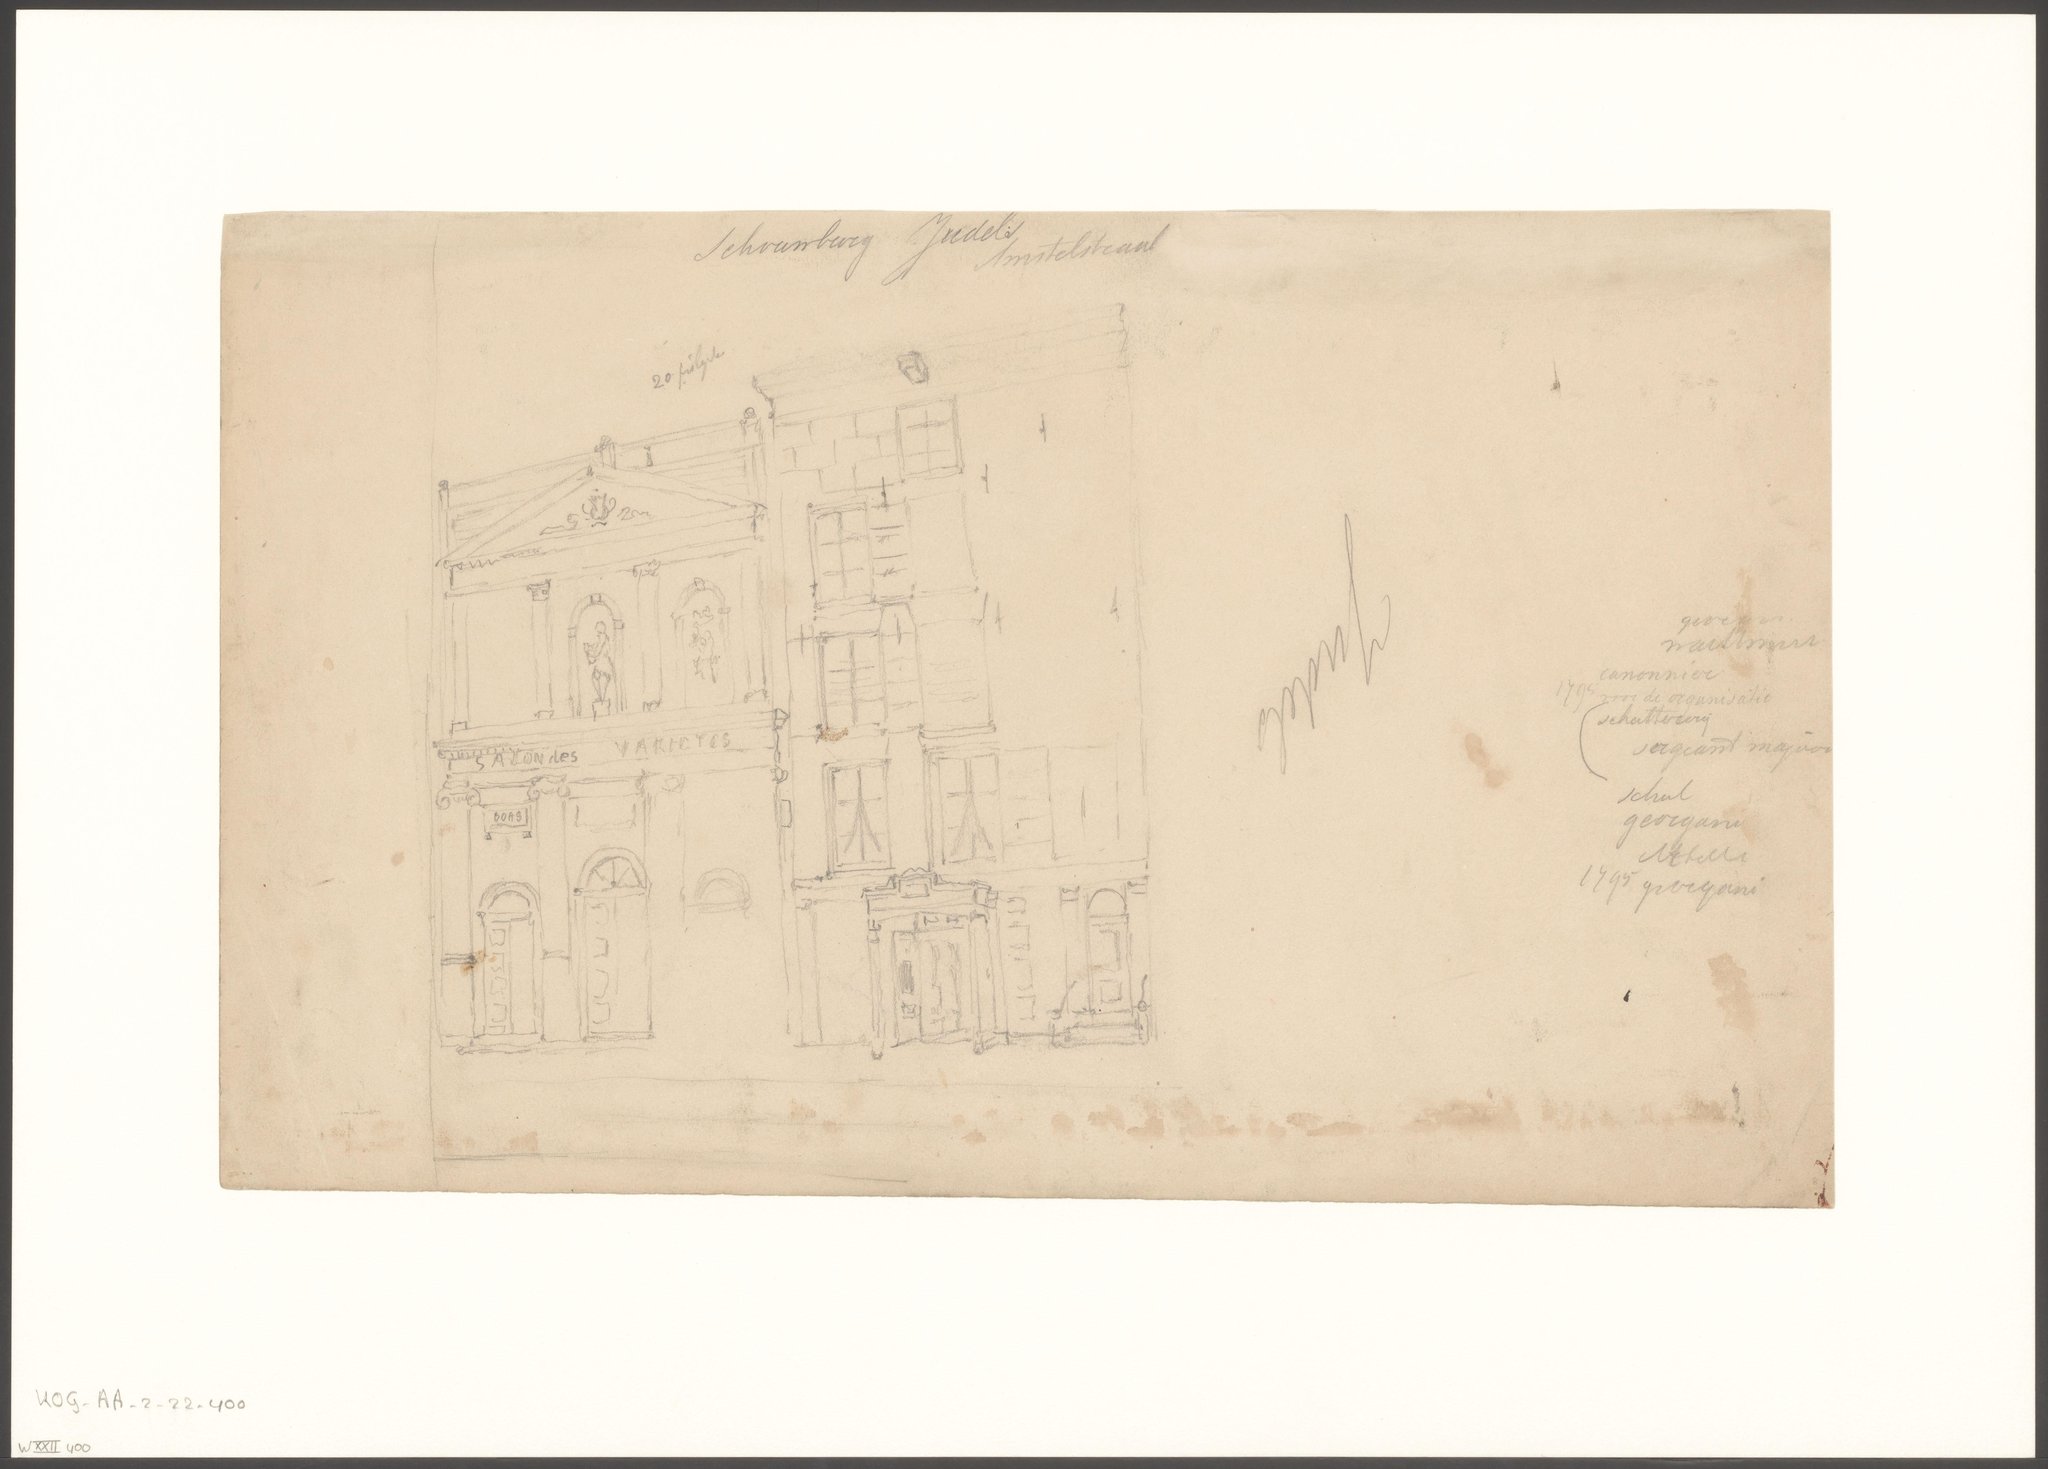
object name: drawing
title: Gezicht op de Salon des Variétés aan de Amstelstraat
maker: johan george lodewijk rieke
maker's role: draughtsman, print maker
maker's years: 1817-1898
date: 1844-1898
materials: paper, pencil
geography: amsterdam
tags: city-view in general; 'veduta', theatre (building)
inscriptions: inscription: ‘Schouwburg Judels / Amstelstraat (...) [...]che / 1795 g[...]ani’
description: Tekening binnen de Atlas Van Eck ingedeeld op wijknummer 22.